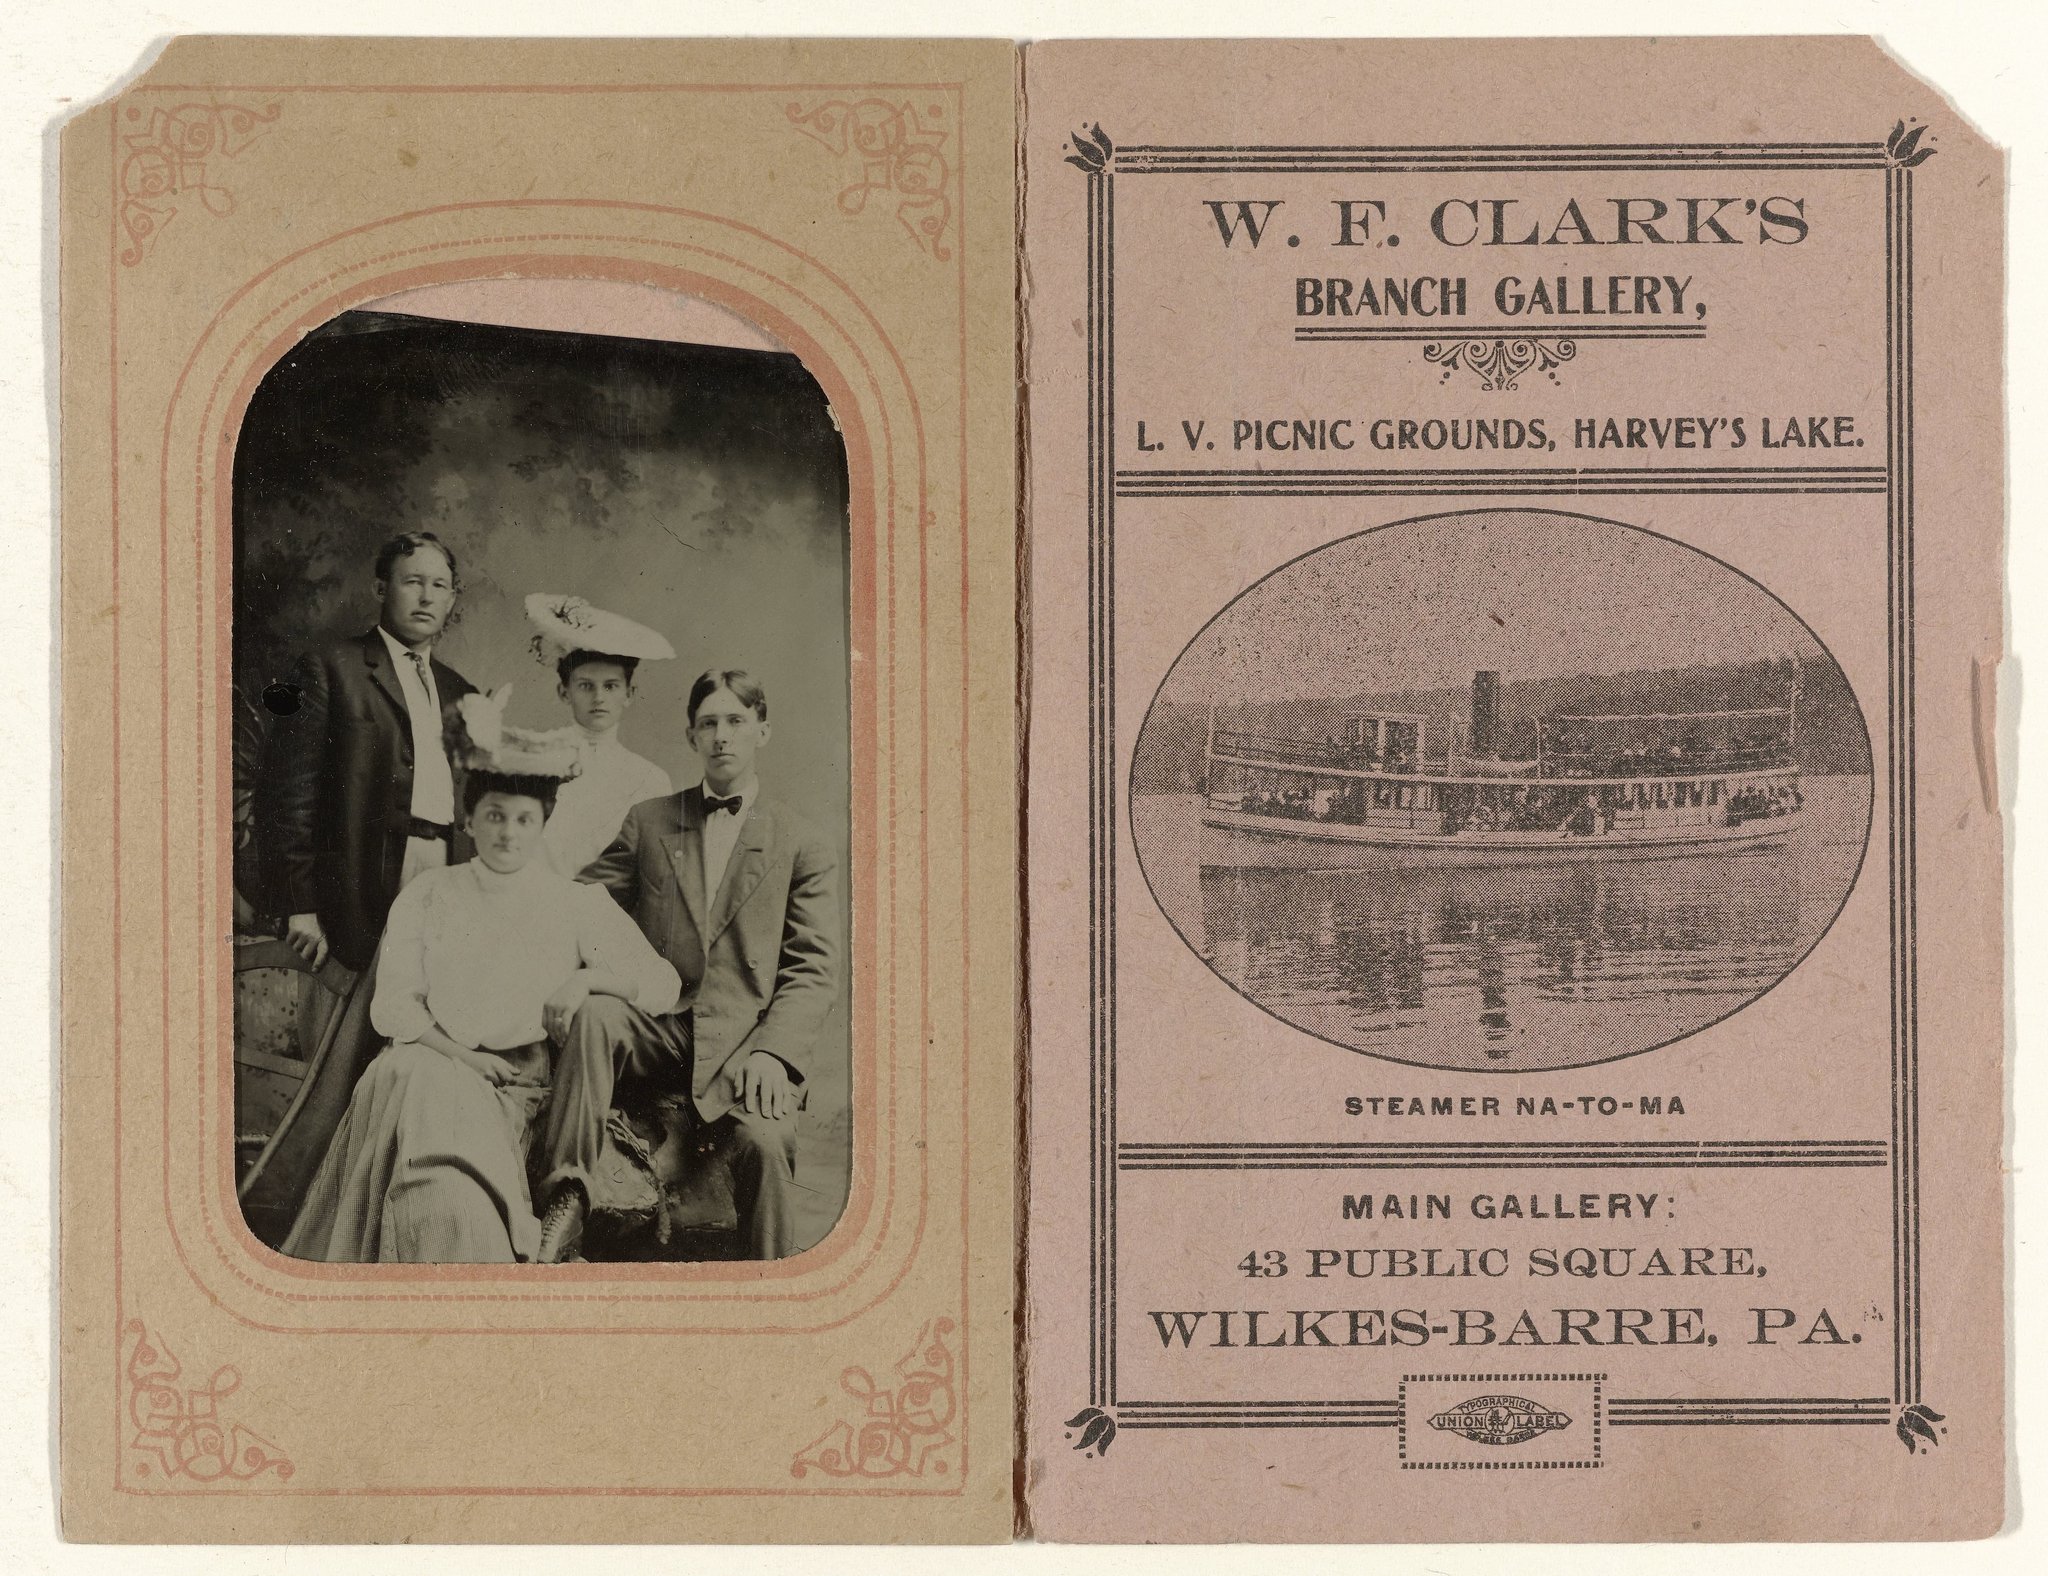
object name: photograph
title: Portret van twee mannen en twee vrouwen met stoomschip Natoma, Harvey’s Lake, Pennsylvania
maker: w.f. clark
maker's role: fotograaf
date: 1900-1920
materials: metal, paper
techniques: ferrotyping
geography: harvey's lake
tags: historical persons not known by name - bb - woman, ships (in general) (+ propulsion of vehicle, ship, etc. by steam), outing, pleasure trip, historical persons not known by name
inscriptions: address: ‘W.F. CLARK’S // BRANCH GALLERY, // L.V. PICNIC GROUNDS, HARVEY’S LAKE. // STEAMER NA-TO-MA // MAIN GALLERY: // 43 PUBLIC SQUARE, // WILKES-BARRE, PA’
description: Portret van twee mannen en twee vrouwen, in passepartout met gedrukte foto van het stoomschip Natoma, Harvey’s Lake, Pennsylvania.